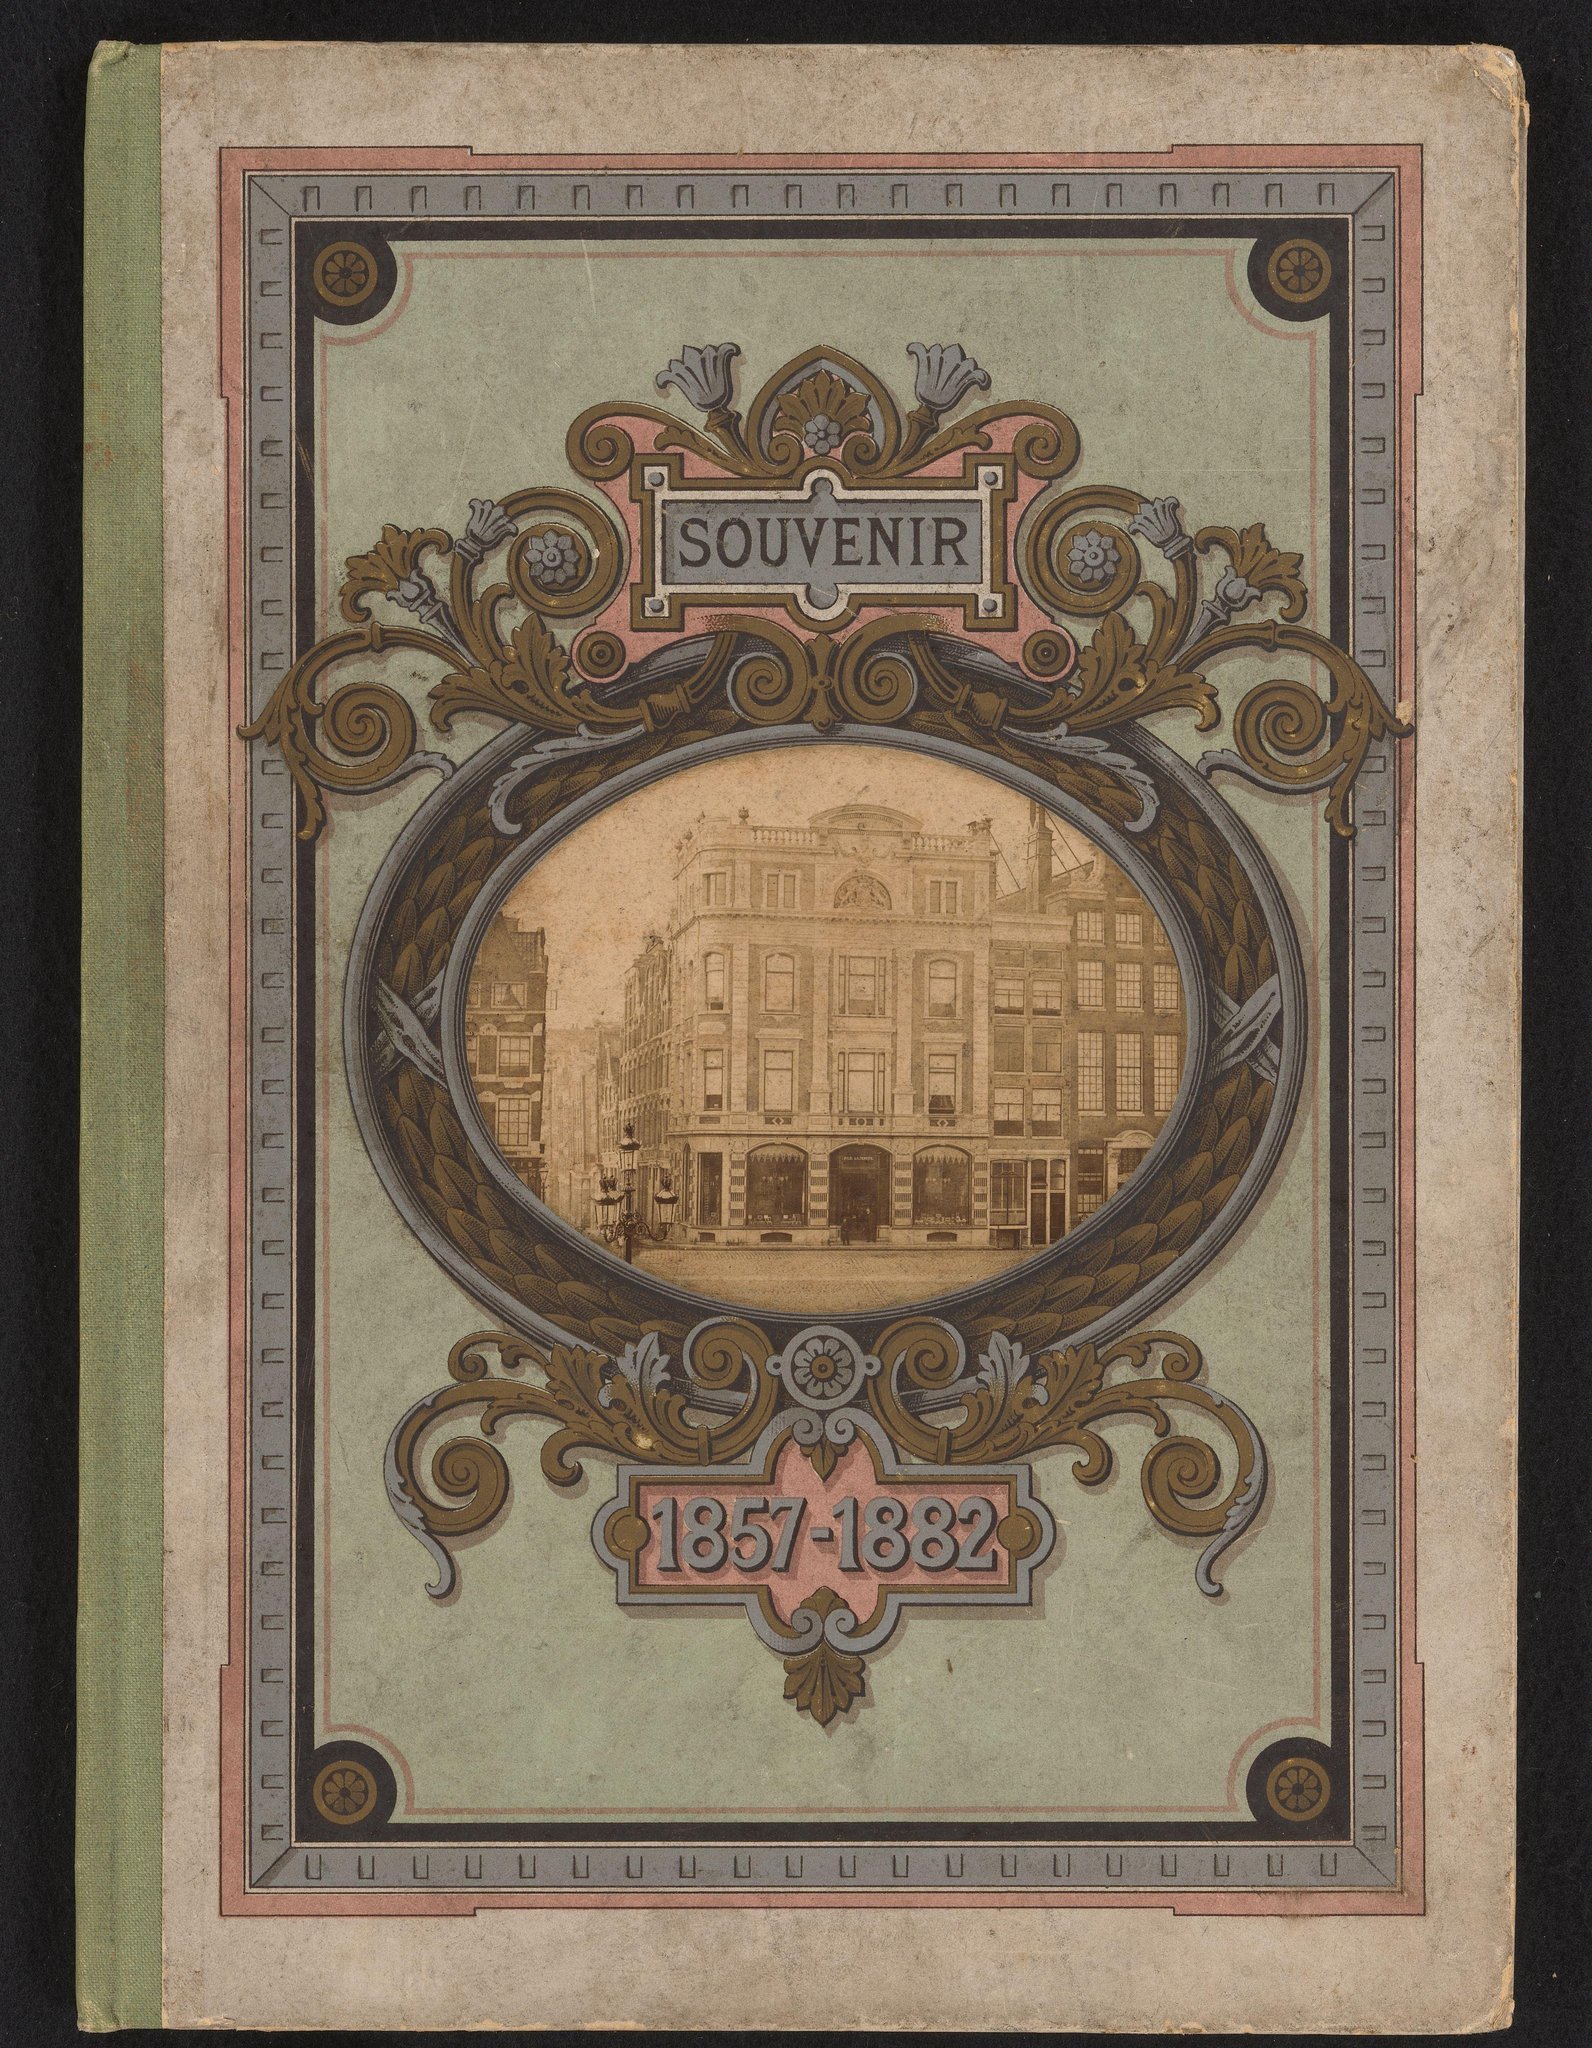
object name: book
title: Souvenir aan het 25-jarig huwelijksfeest van den Heer Hendrik Willem Nijman en Mevrouw Catherina Maria Beijer, Amsterdam, 22 October 1882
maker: Anonymous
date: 1882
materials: cardboard, linen, paper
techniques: albumen print, moire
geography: amsterdam